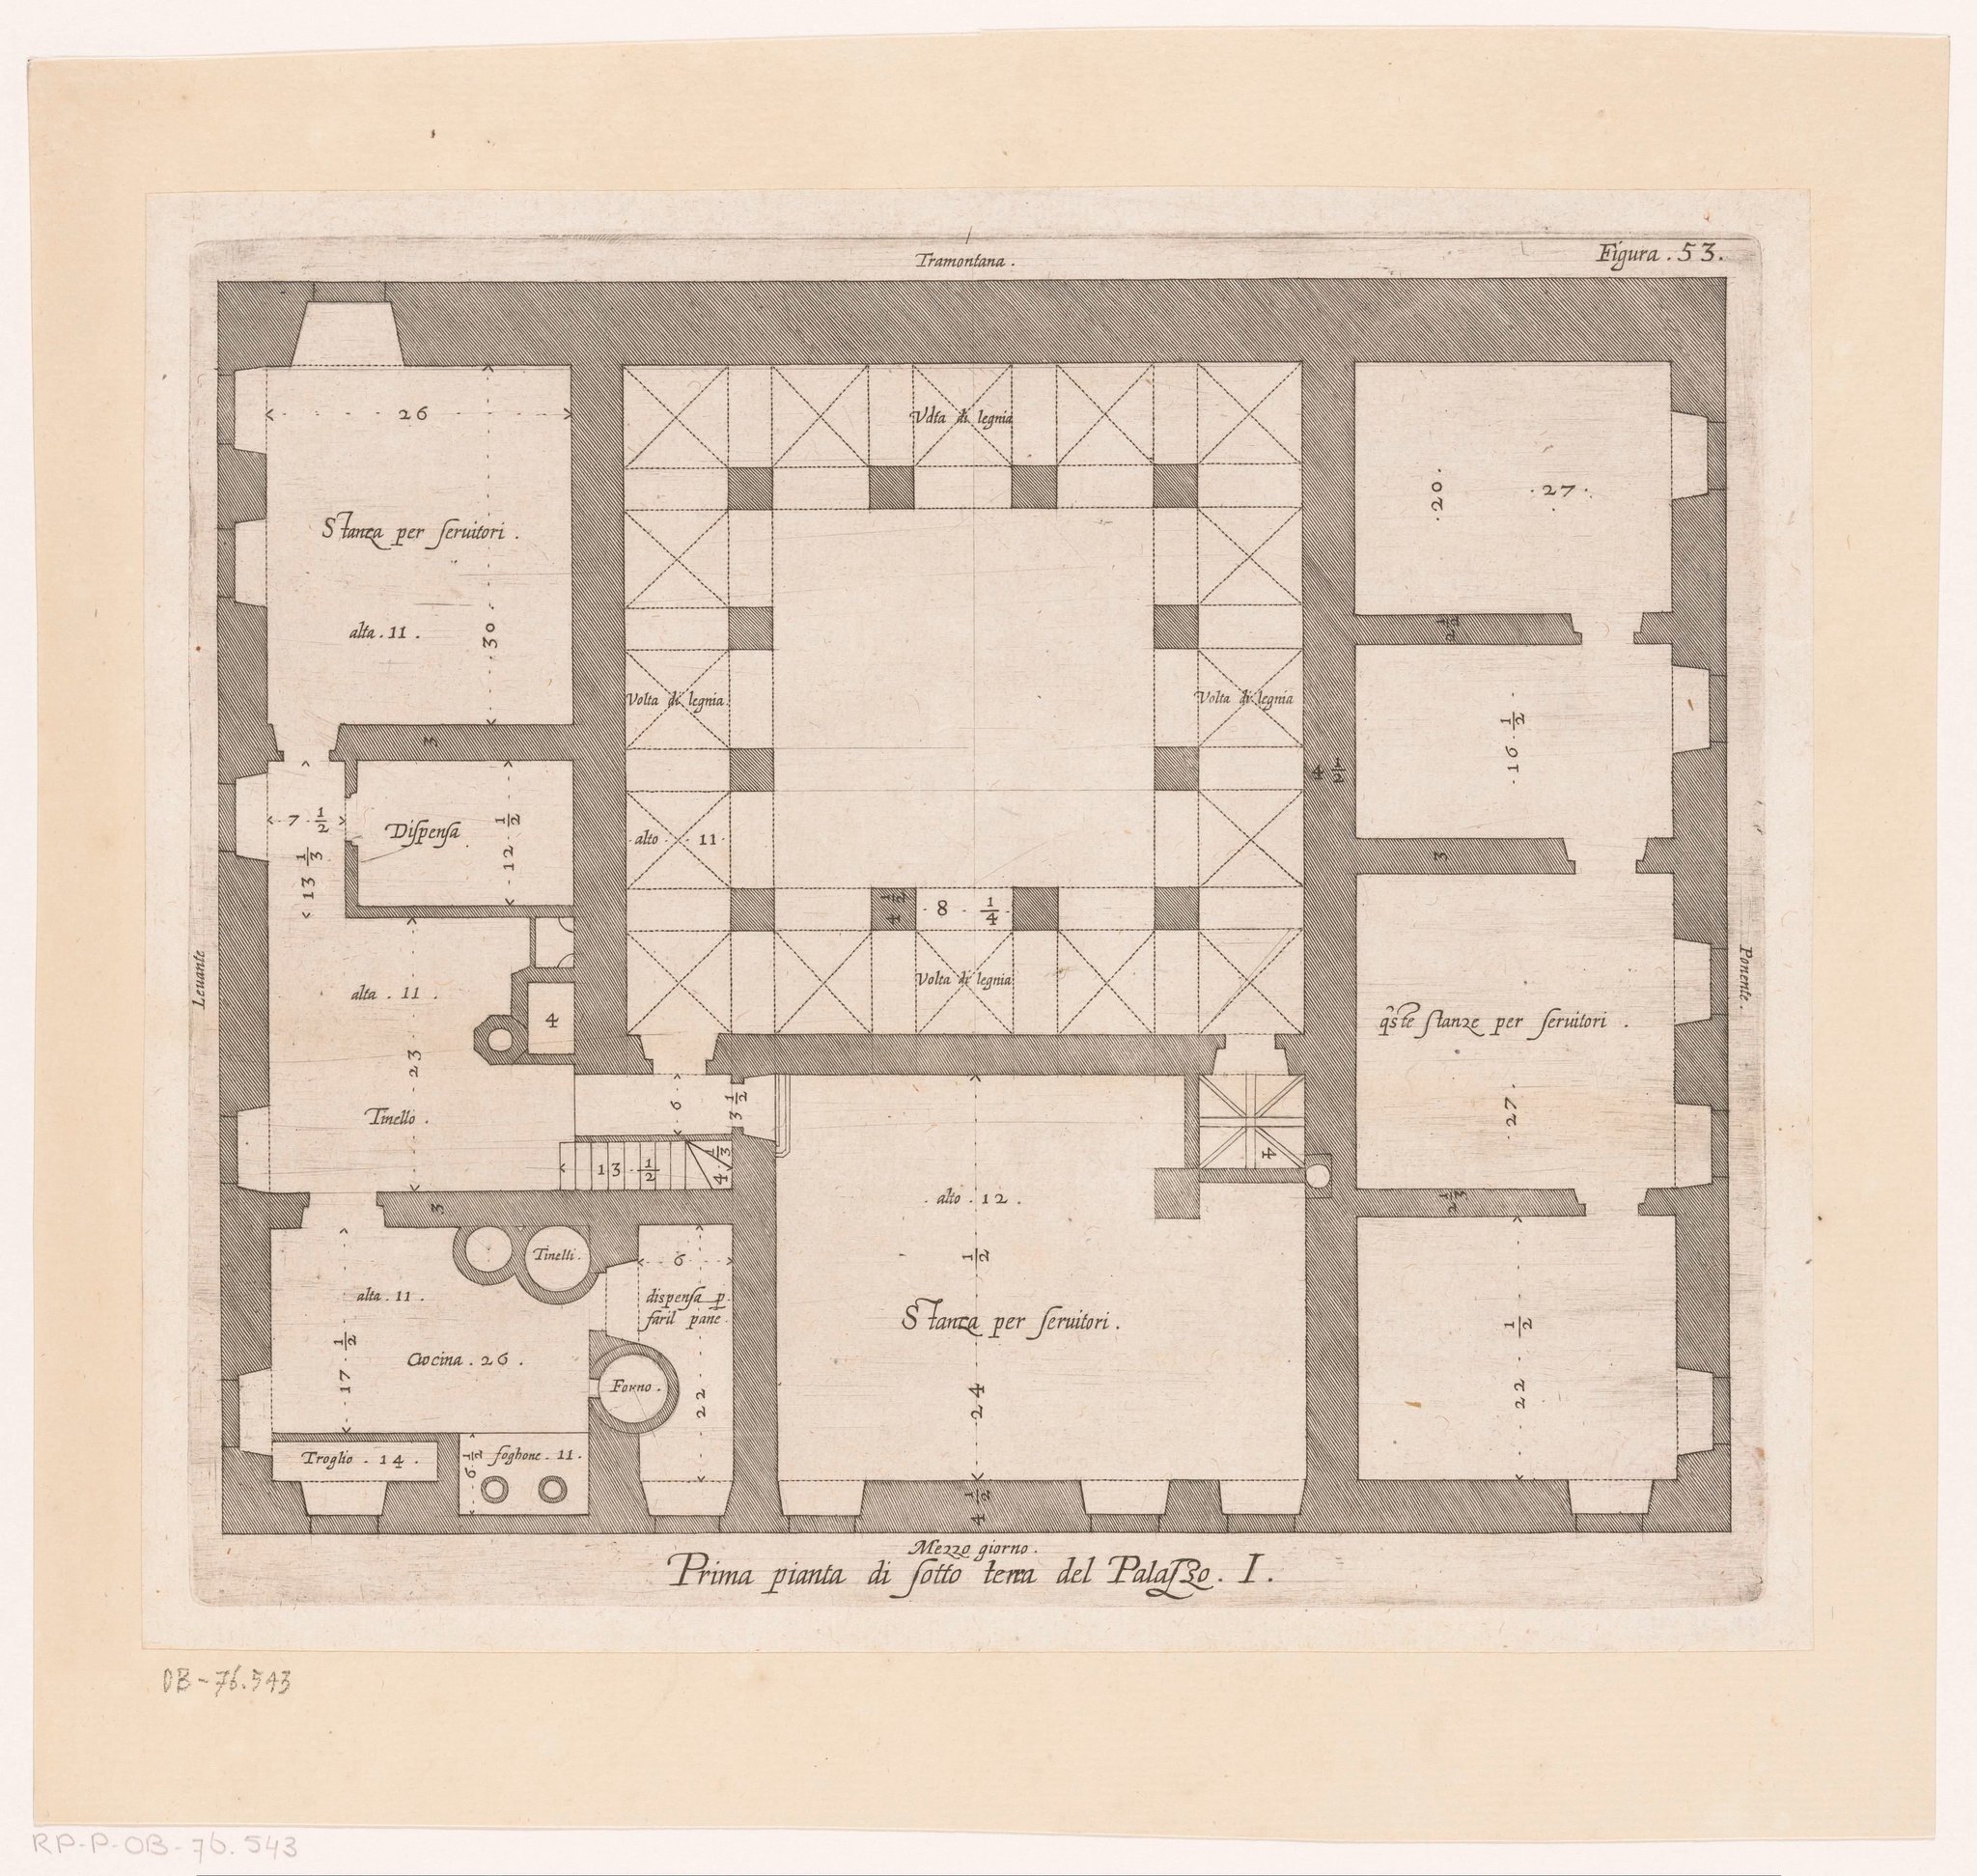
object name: print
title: Prima pianta di sotto terra del Palazzo. I.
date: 1622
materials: paper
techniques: engraving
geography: antwerp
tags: hôtel, i.e. small palace in city - aa - civic architecture: inside, plan ~ architecture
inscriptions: collector's mark: Lugt 240